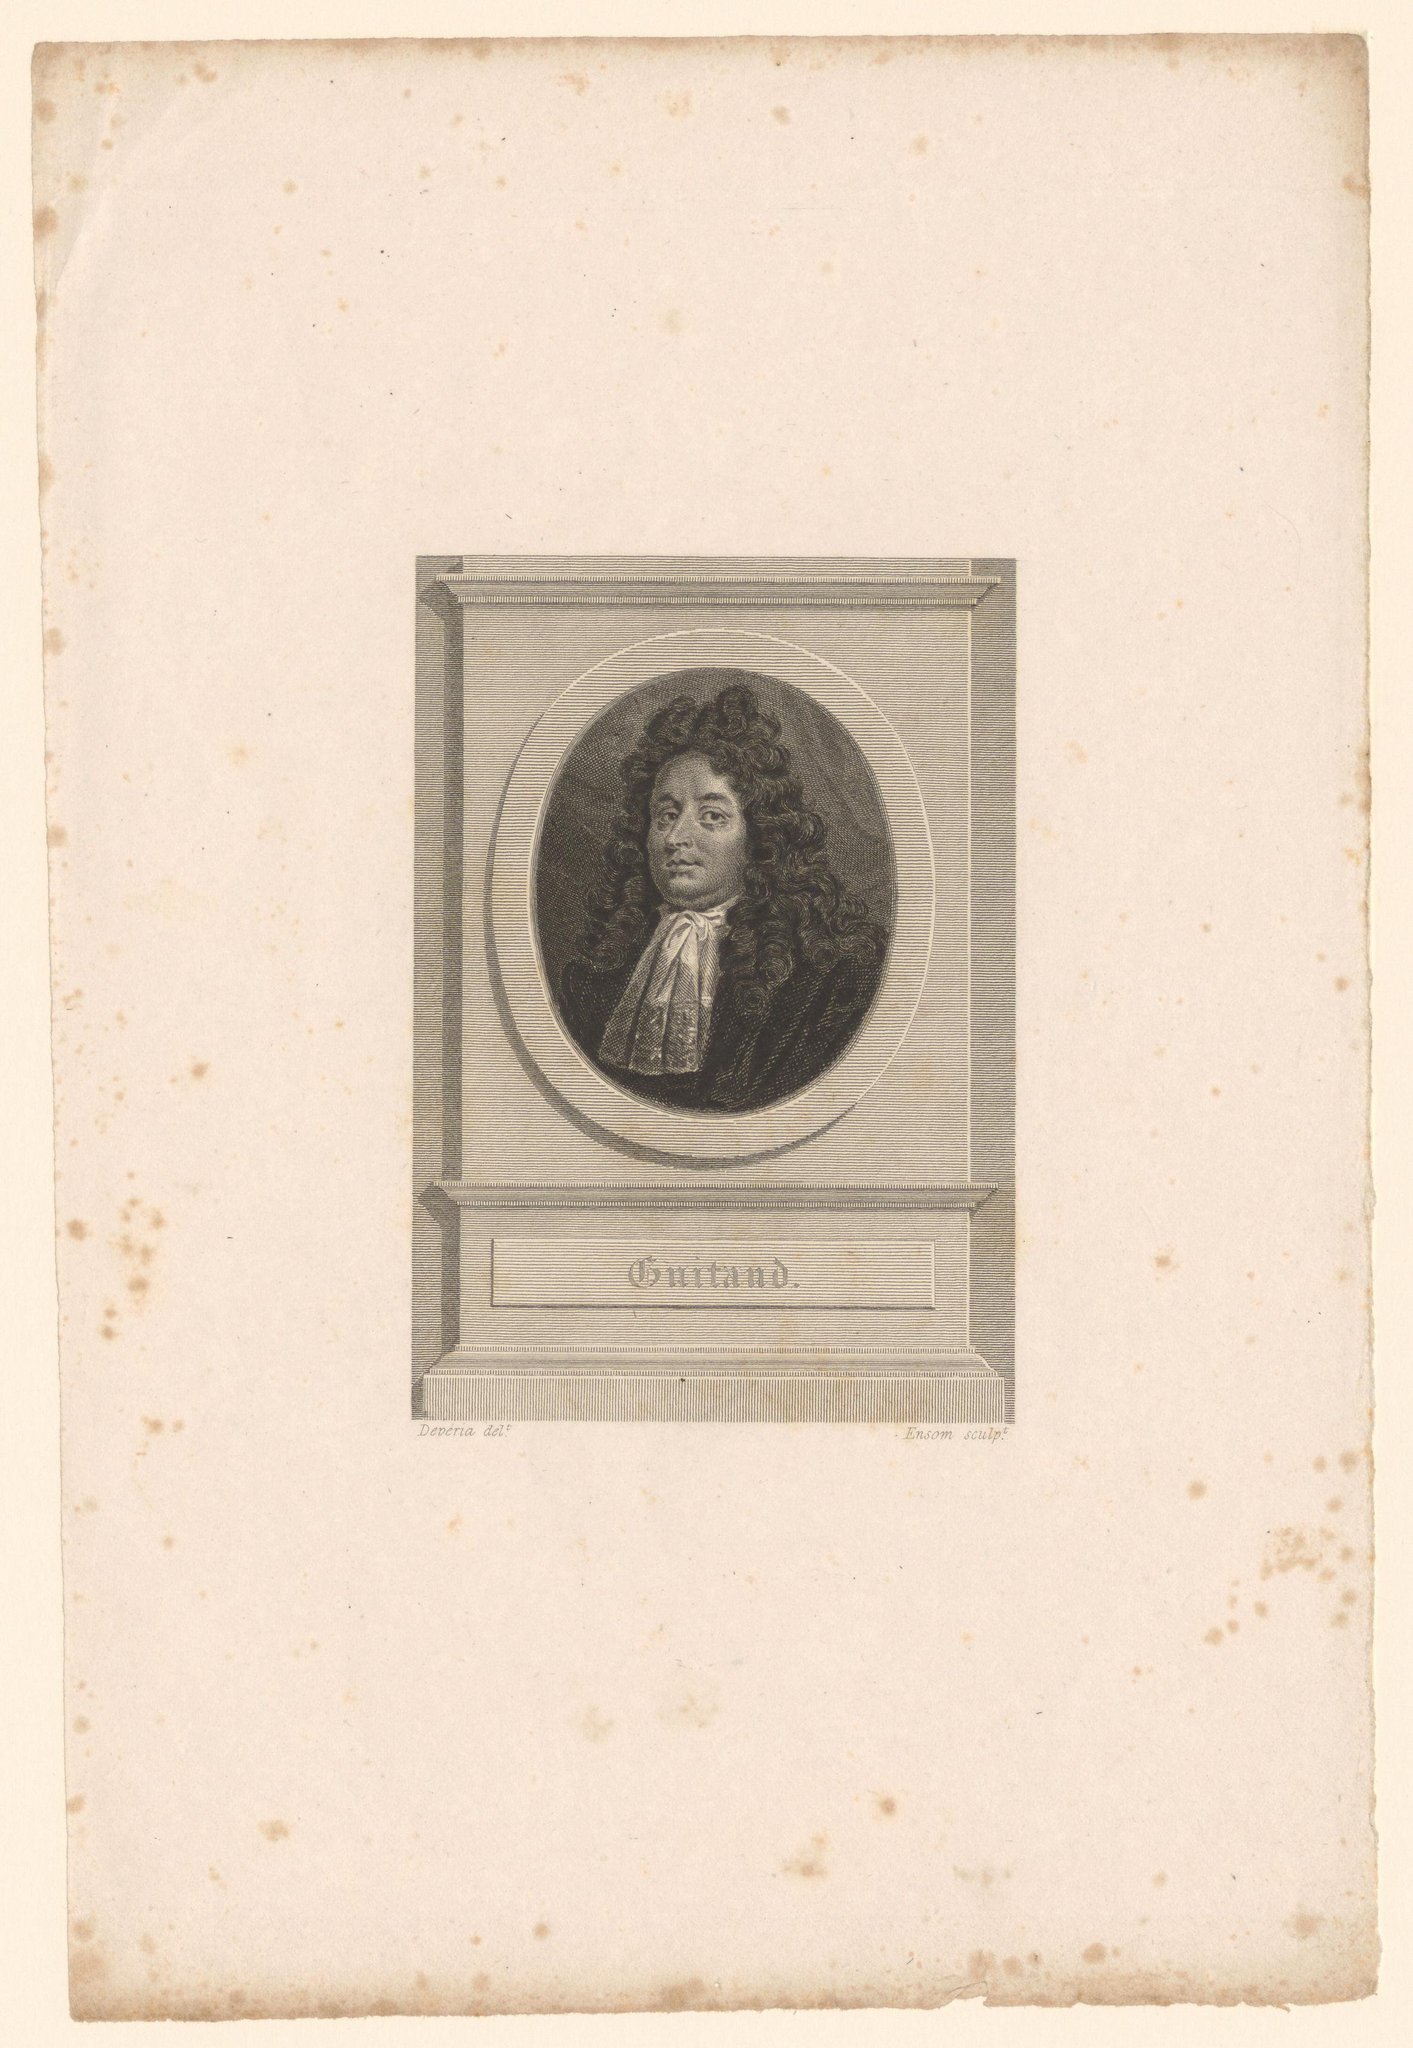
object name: print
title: Guitaud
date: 1830-1832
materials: paper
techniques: etching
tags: paris, historical persons, officer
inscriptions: collector's mark: Lugt 2228